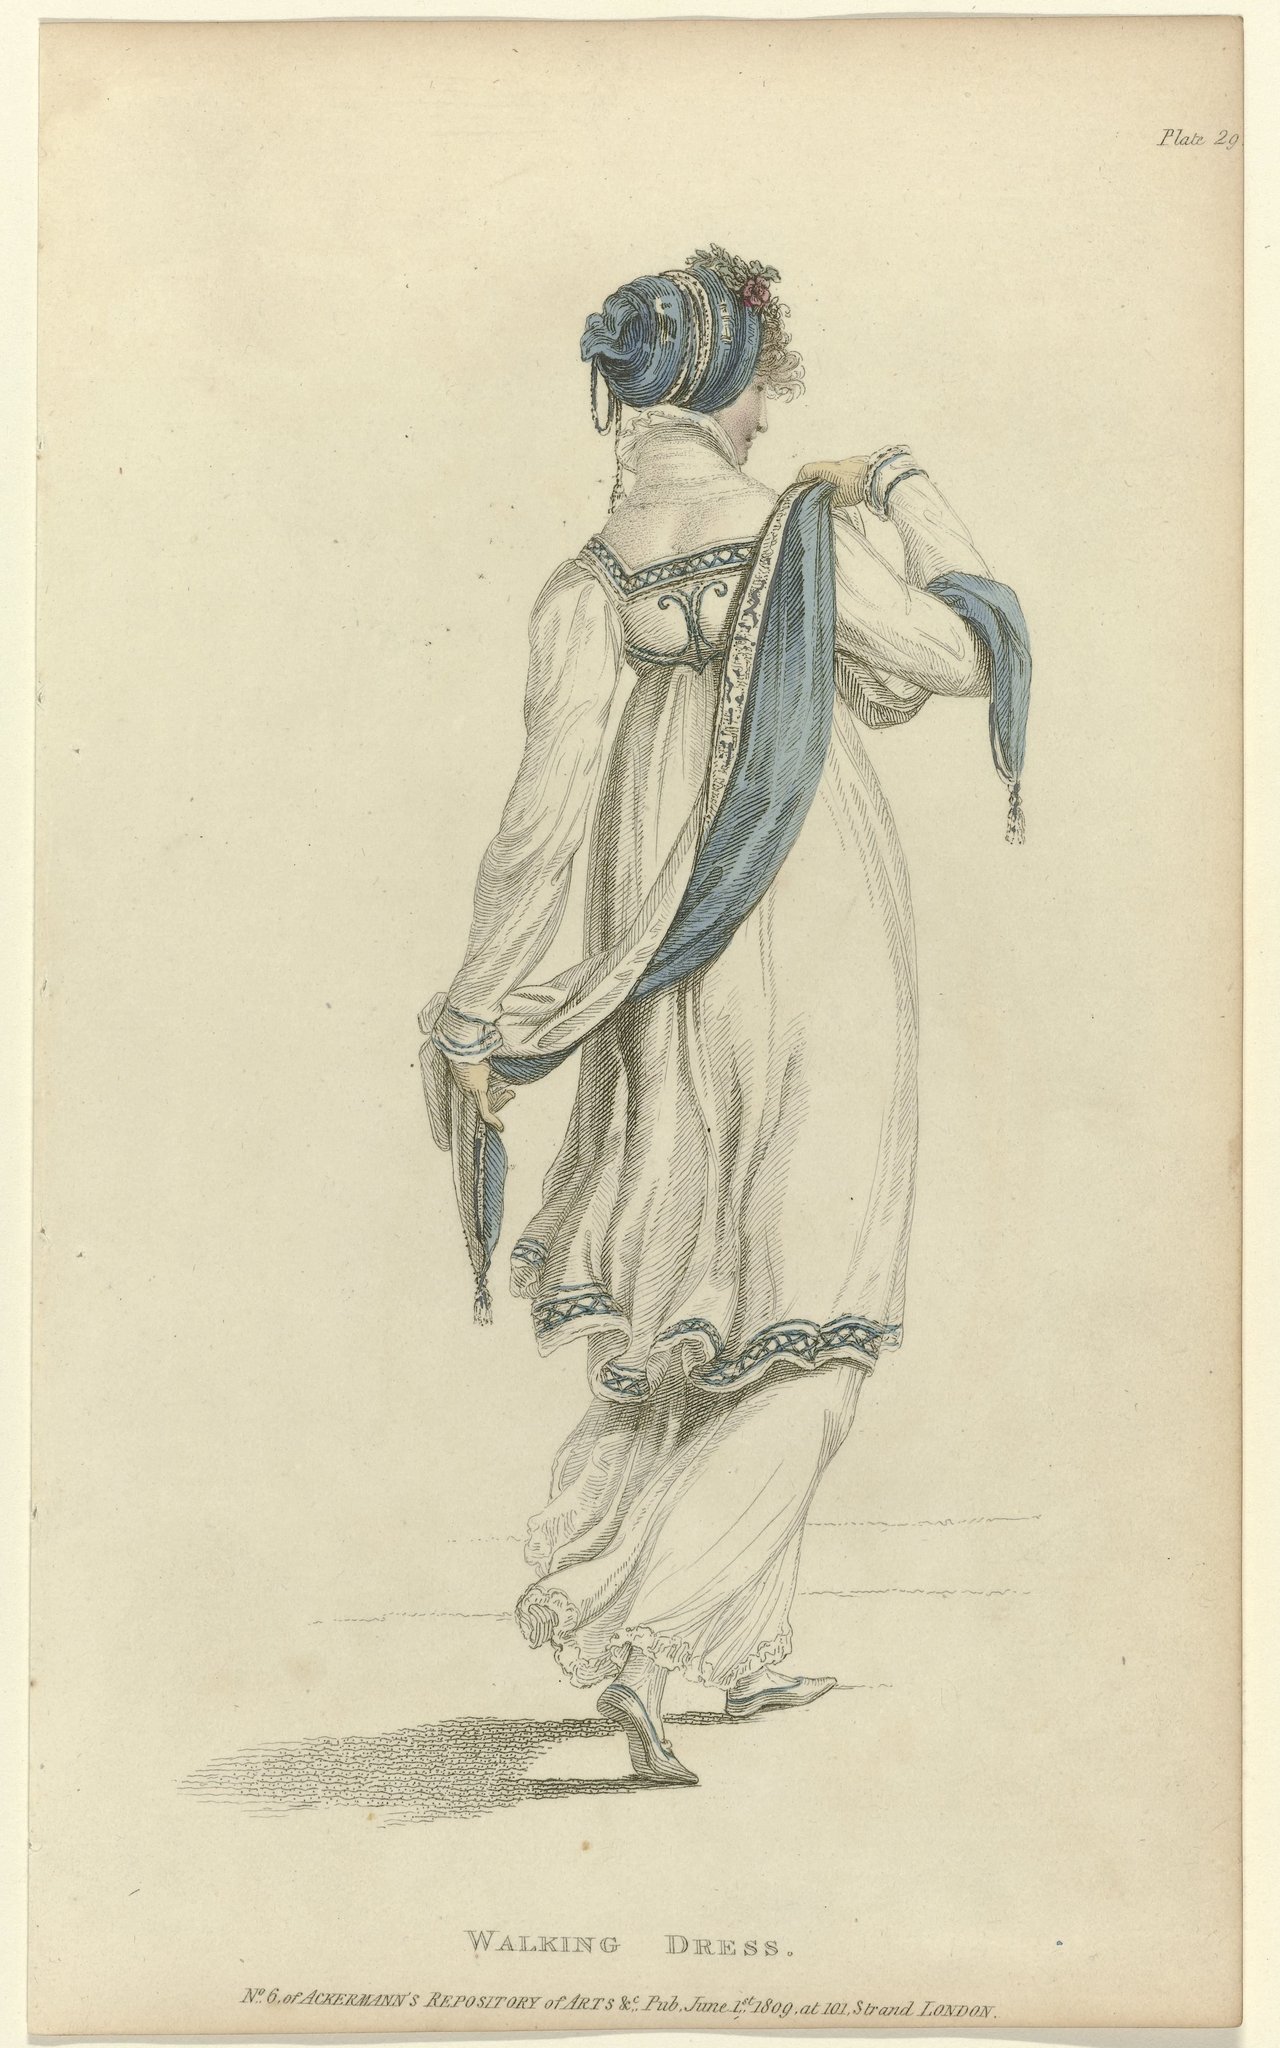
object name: fashion print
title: Ackermann's Repository of Arts, 1 june 1809, Pl. 29, No. 6: Walking Dress.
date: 1809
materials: paper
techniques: etching, hand coloring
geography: london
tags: head-gear: turban (+ women's clothes), clothing for the upper part of the body (shawl) (+ women's clothes), dress, gown: walking dress (+ women's clothes), fashion plates, shoes, sandals (+ women's clothes), gloves, mittens, etc. (+ women's clothes)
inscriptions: title: ‘Walking dress.’, caption: ‘No. 6 of Ackermann's Repository of Arts & c. Pub. june.1.st 1809 at 101, Strand, London.’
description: Wandeljapon, op de rug en bij de zoom versierd met een geometrisch patroon. Accessoires: tulband, handschoenen, sjaal met aan de uiteinden kwasten, platte schoenen met puntige neuzen. Prent uit het modetijdschrift Ackermann’s ‘Repository of Arts’, Literature, Commerce, manufacture, Fashions and Politics’ (London 1809-1828).